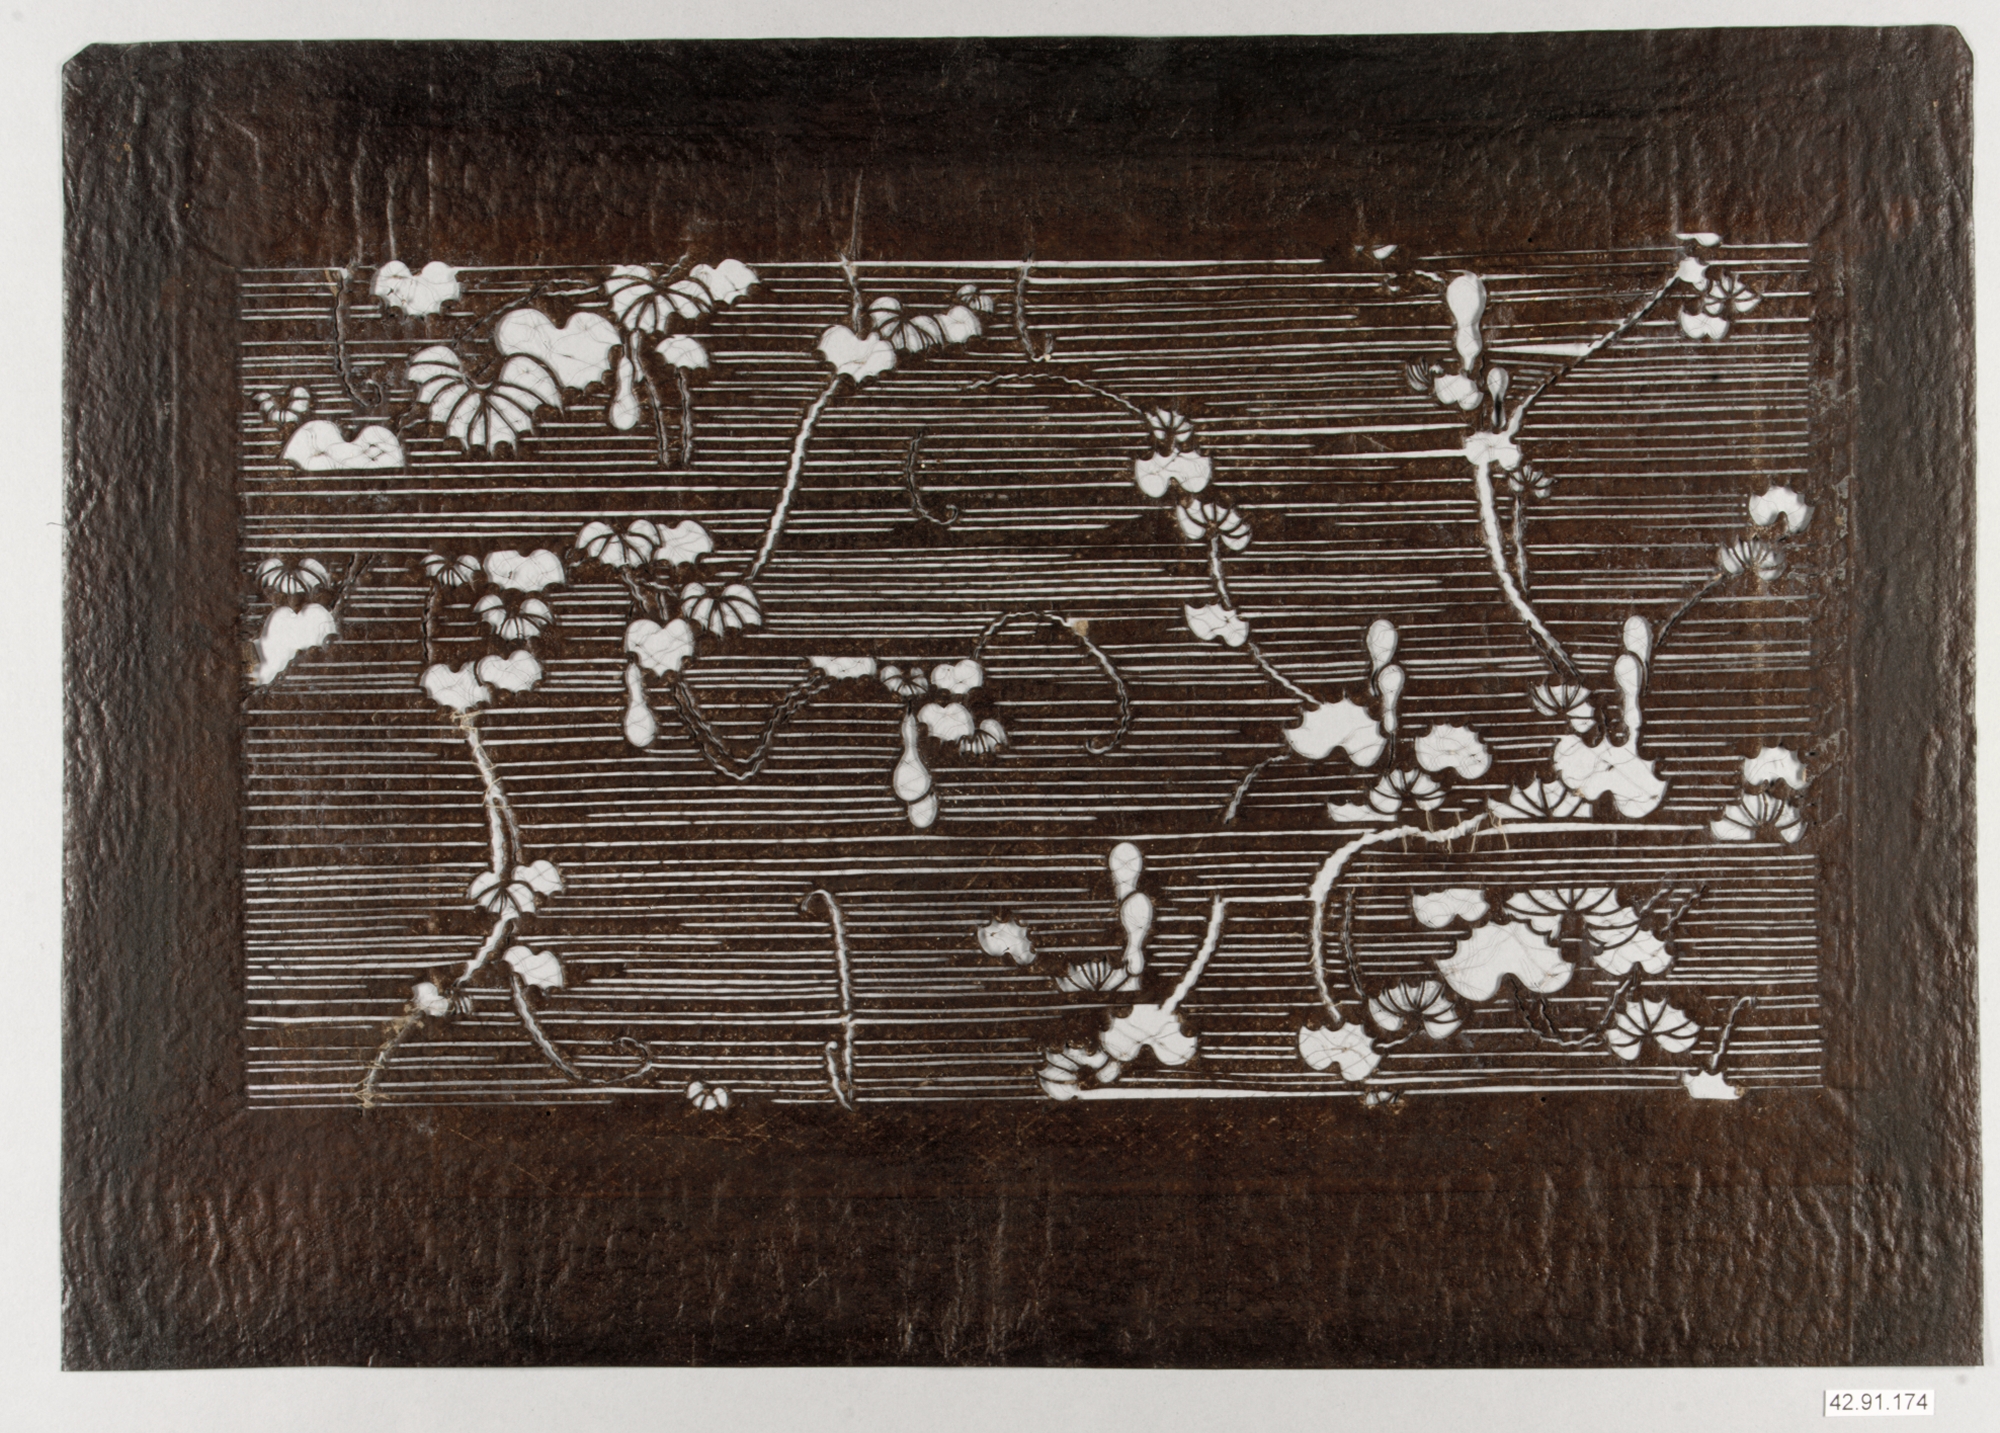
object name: stencil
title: Stencil with Bottle Gourds and Vines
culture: japanese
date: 1801-1900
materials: paper, silk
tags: vines